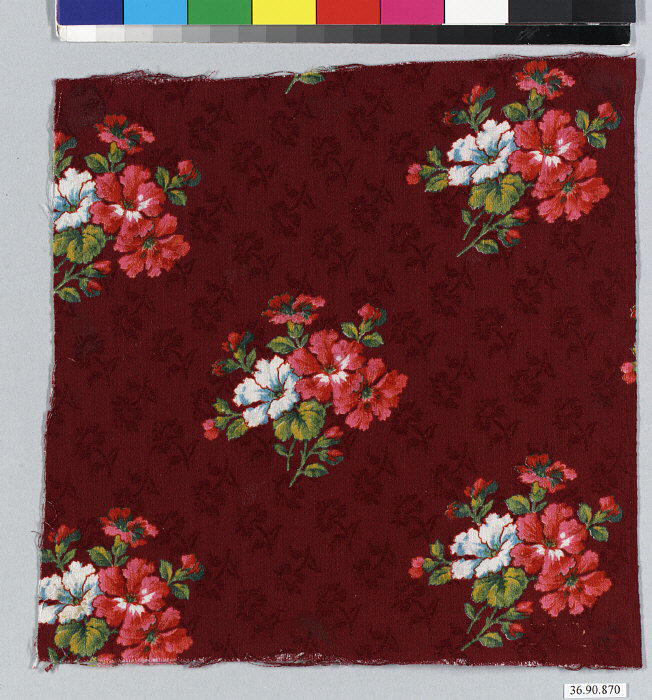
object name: piece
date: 1801-1900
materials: cotton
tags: flowers,leaves